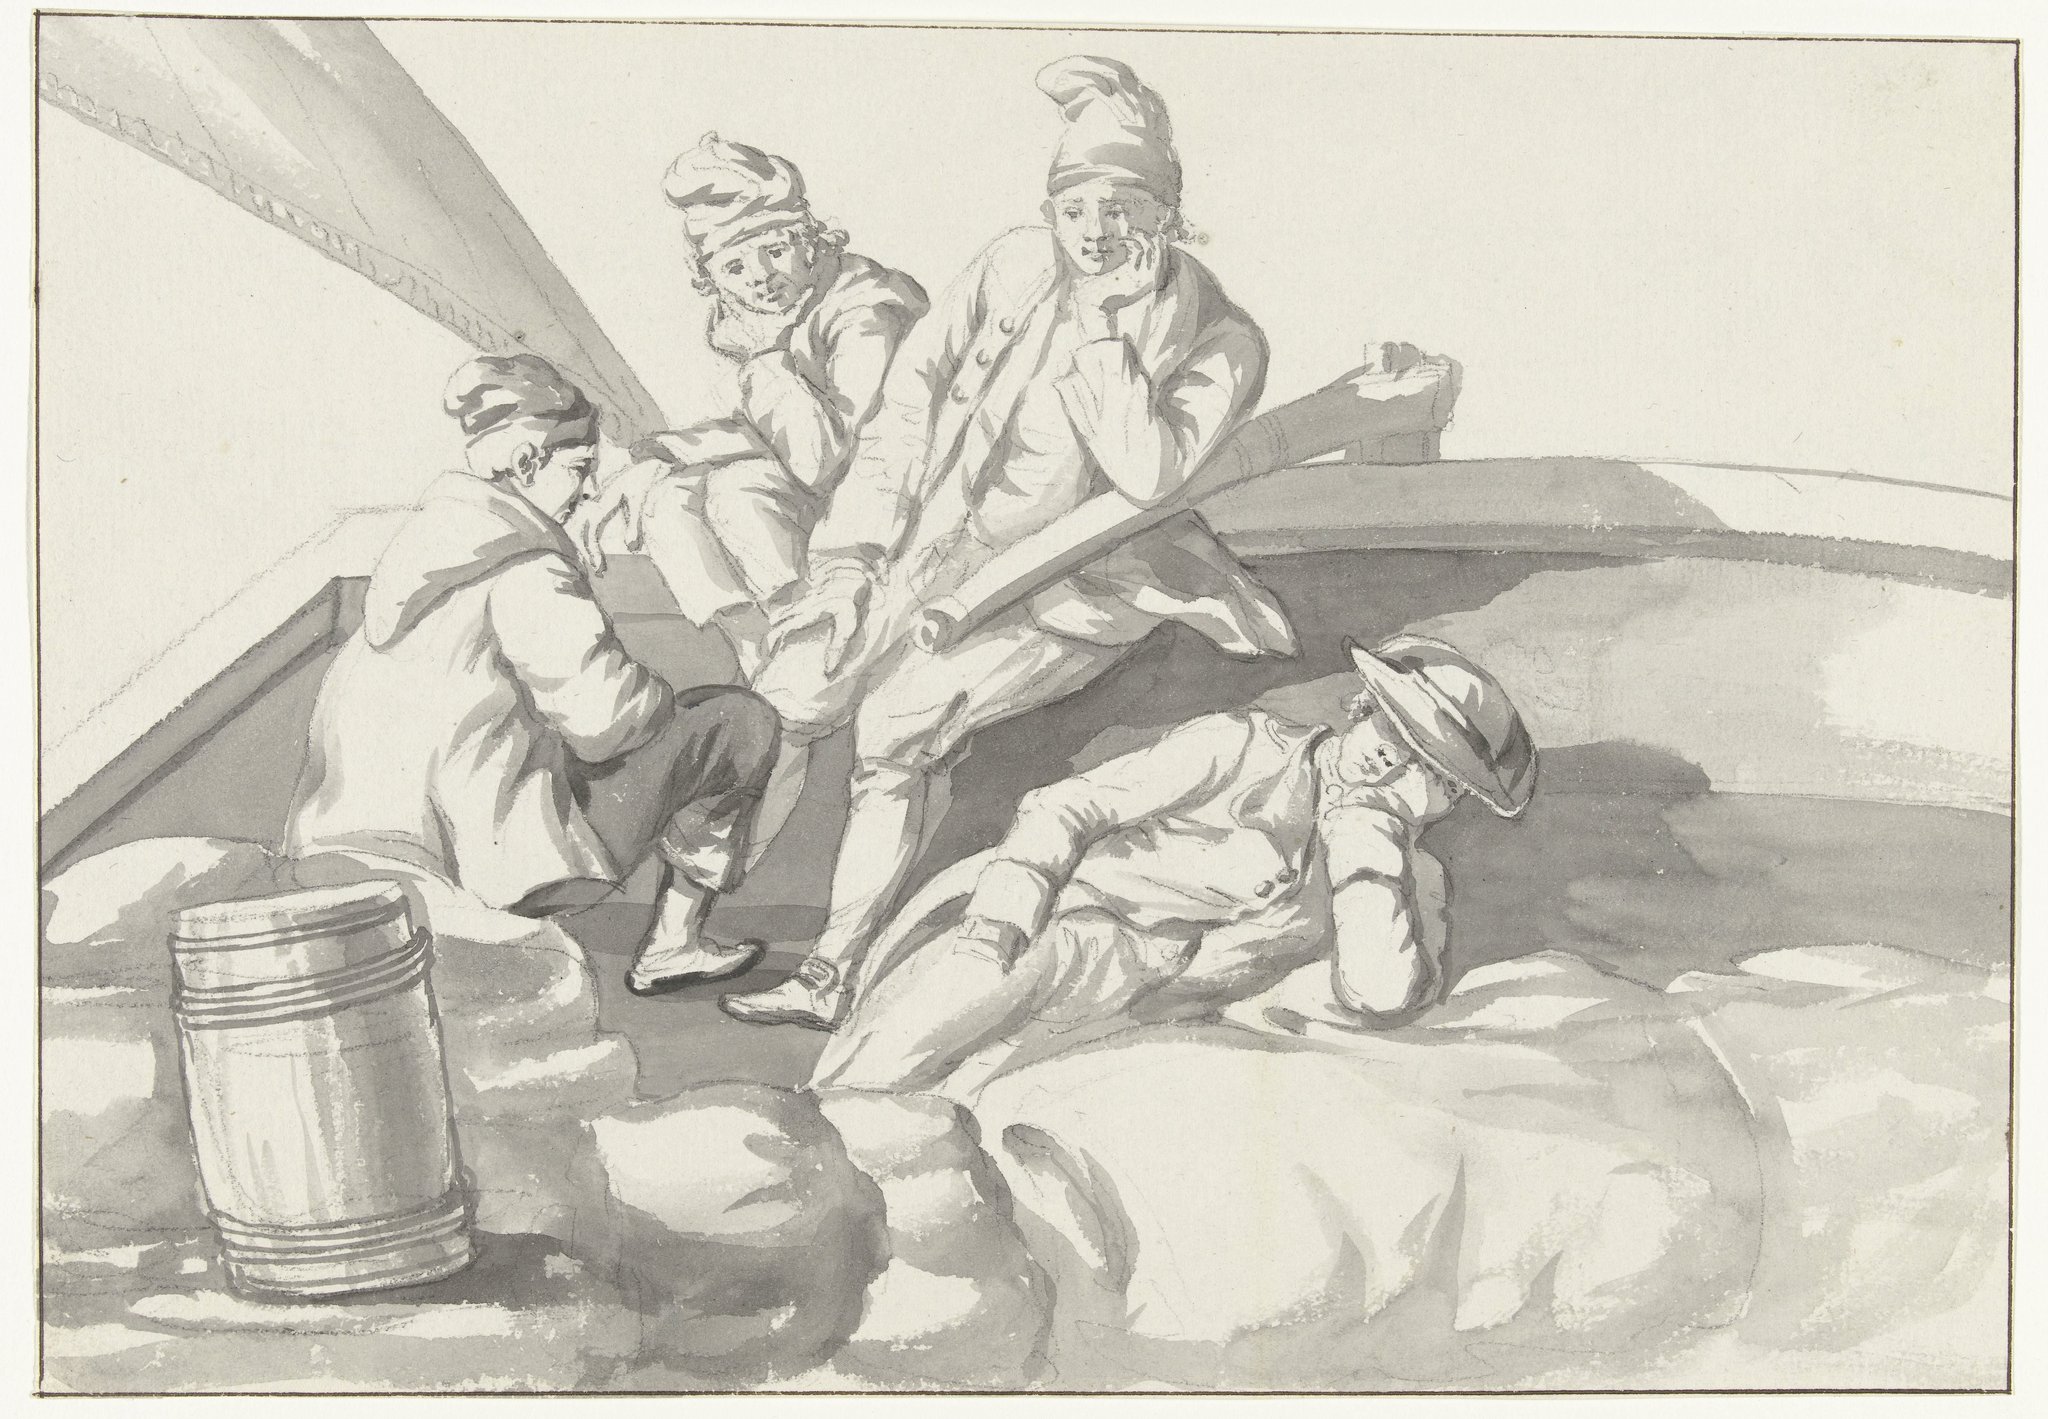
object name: drawing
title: Domestiques & Mariniers à bord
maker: louis ducros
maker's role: draughtsman, print maker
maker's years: 1748-1810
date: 1778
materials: chalk, paper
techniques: brush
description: Tekening uit het album 'Voyage en Italie, en Sicile et à Malte', 1778.